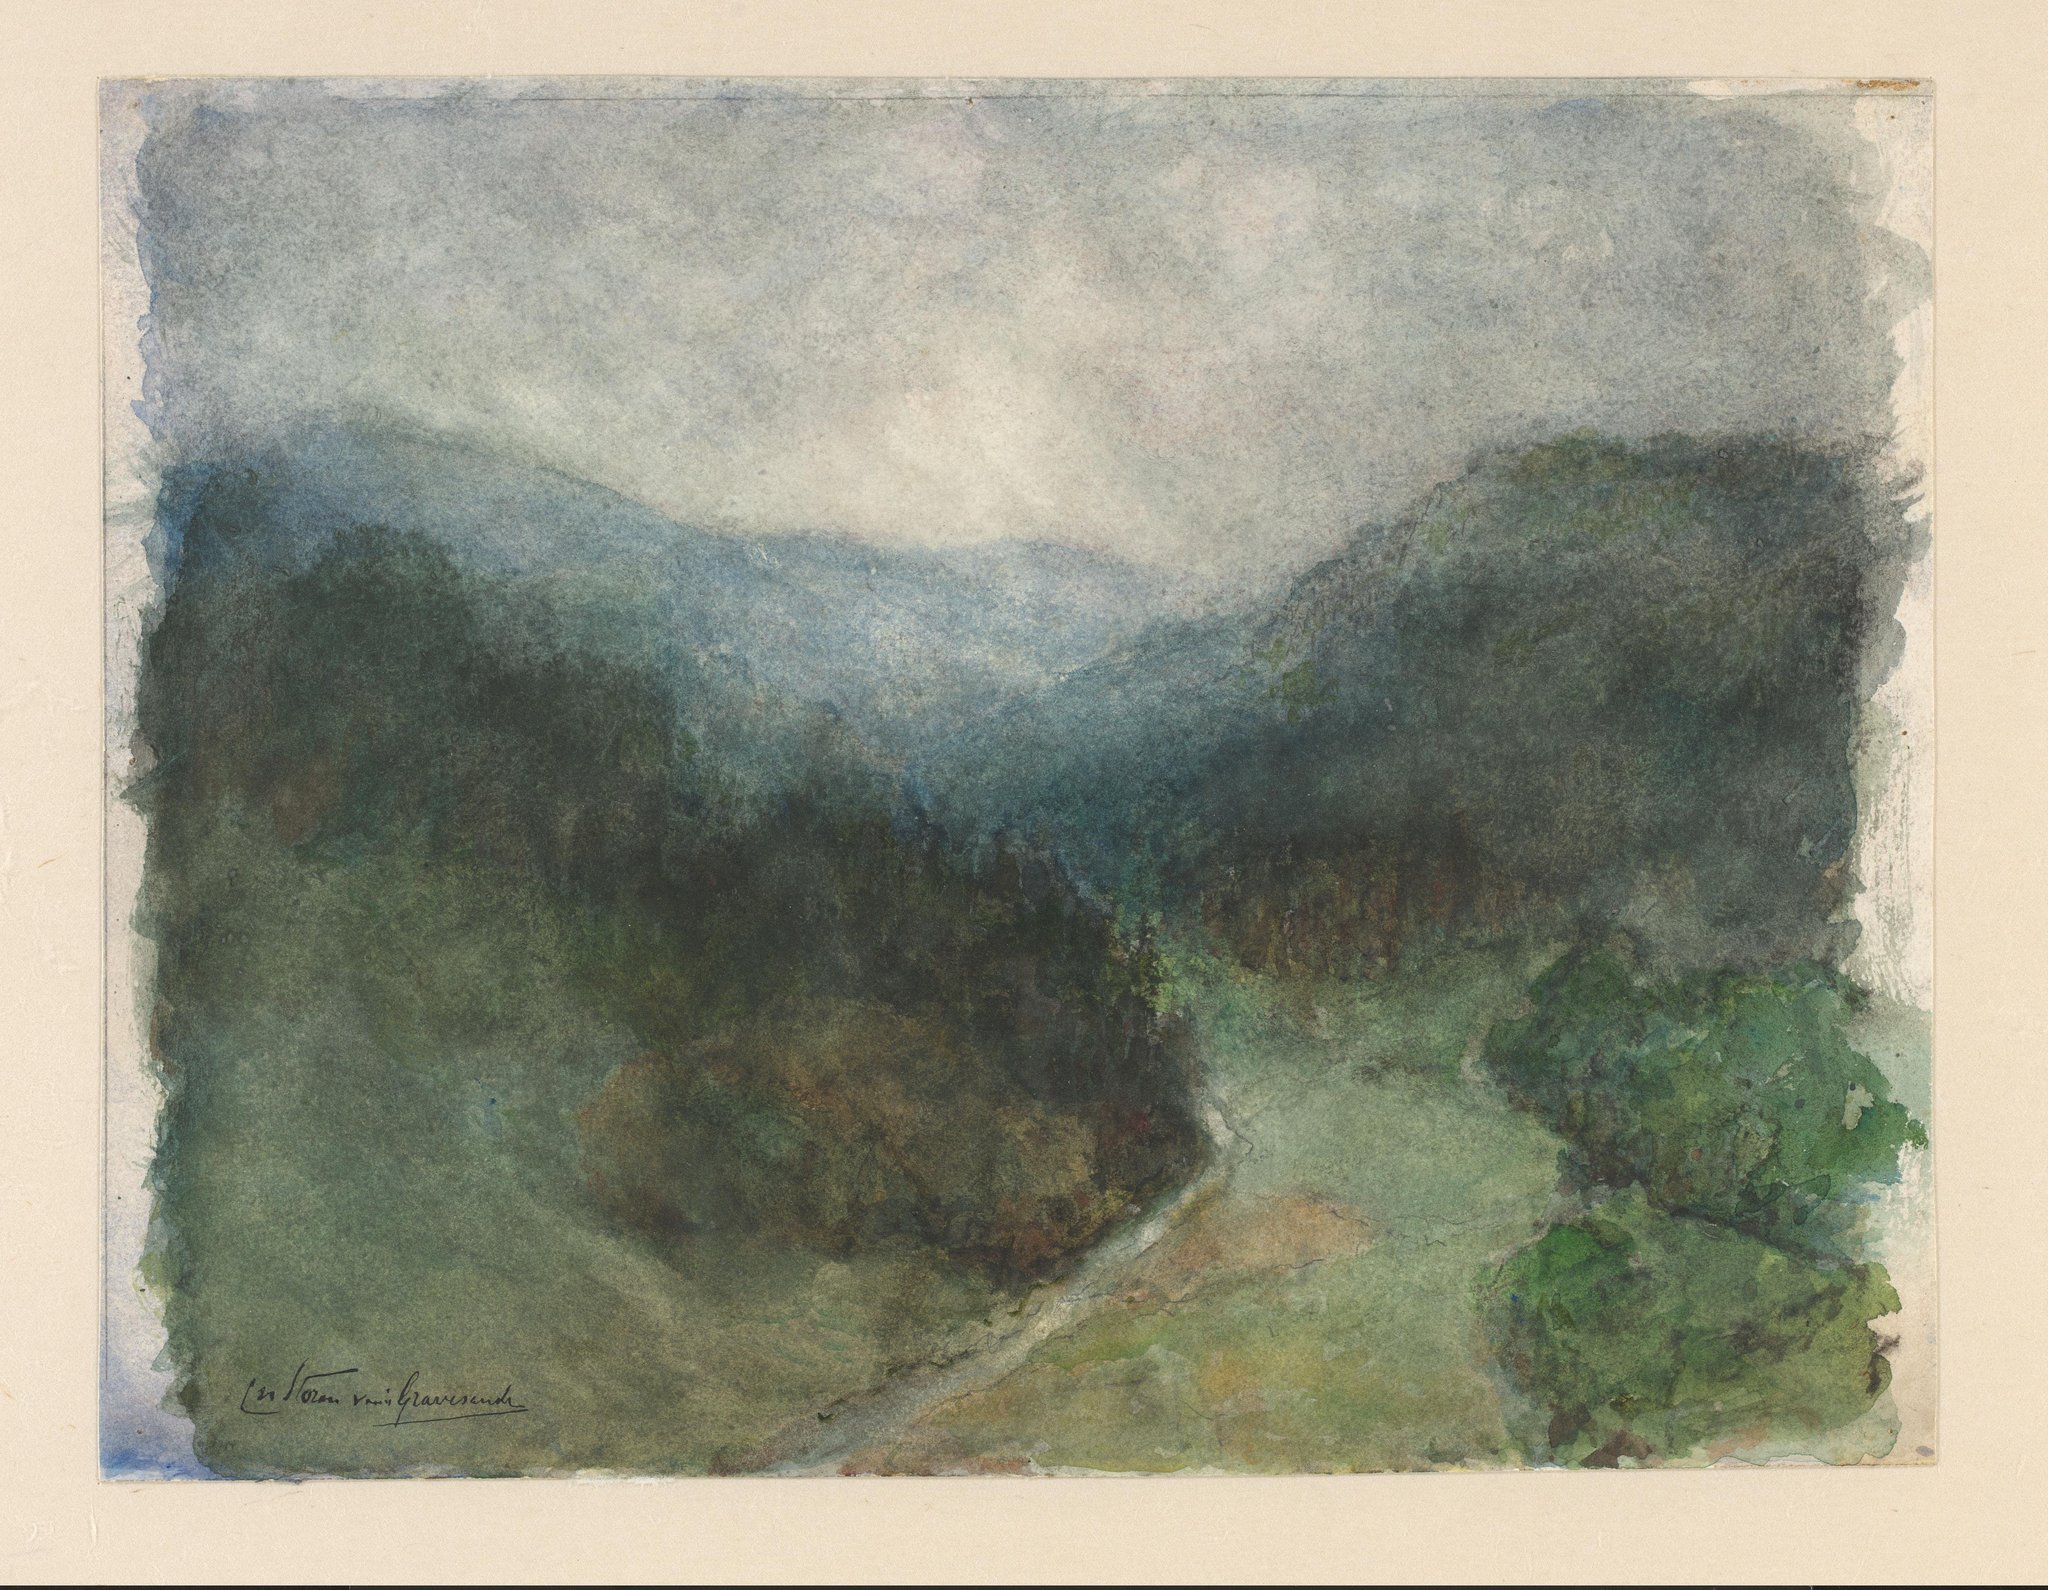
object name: drawing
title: In het Schwarzwald bij Baden-Baden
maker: carel nicolaas storm van s-gravesande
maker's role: draughtsman, print maker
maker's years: 1841-1924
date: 1910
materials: paper, watercolor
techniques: brush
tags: forest, wood, mountains